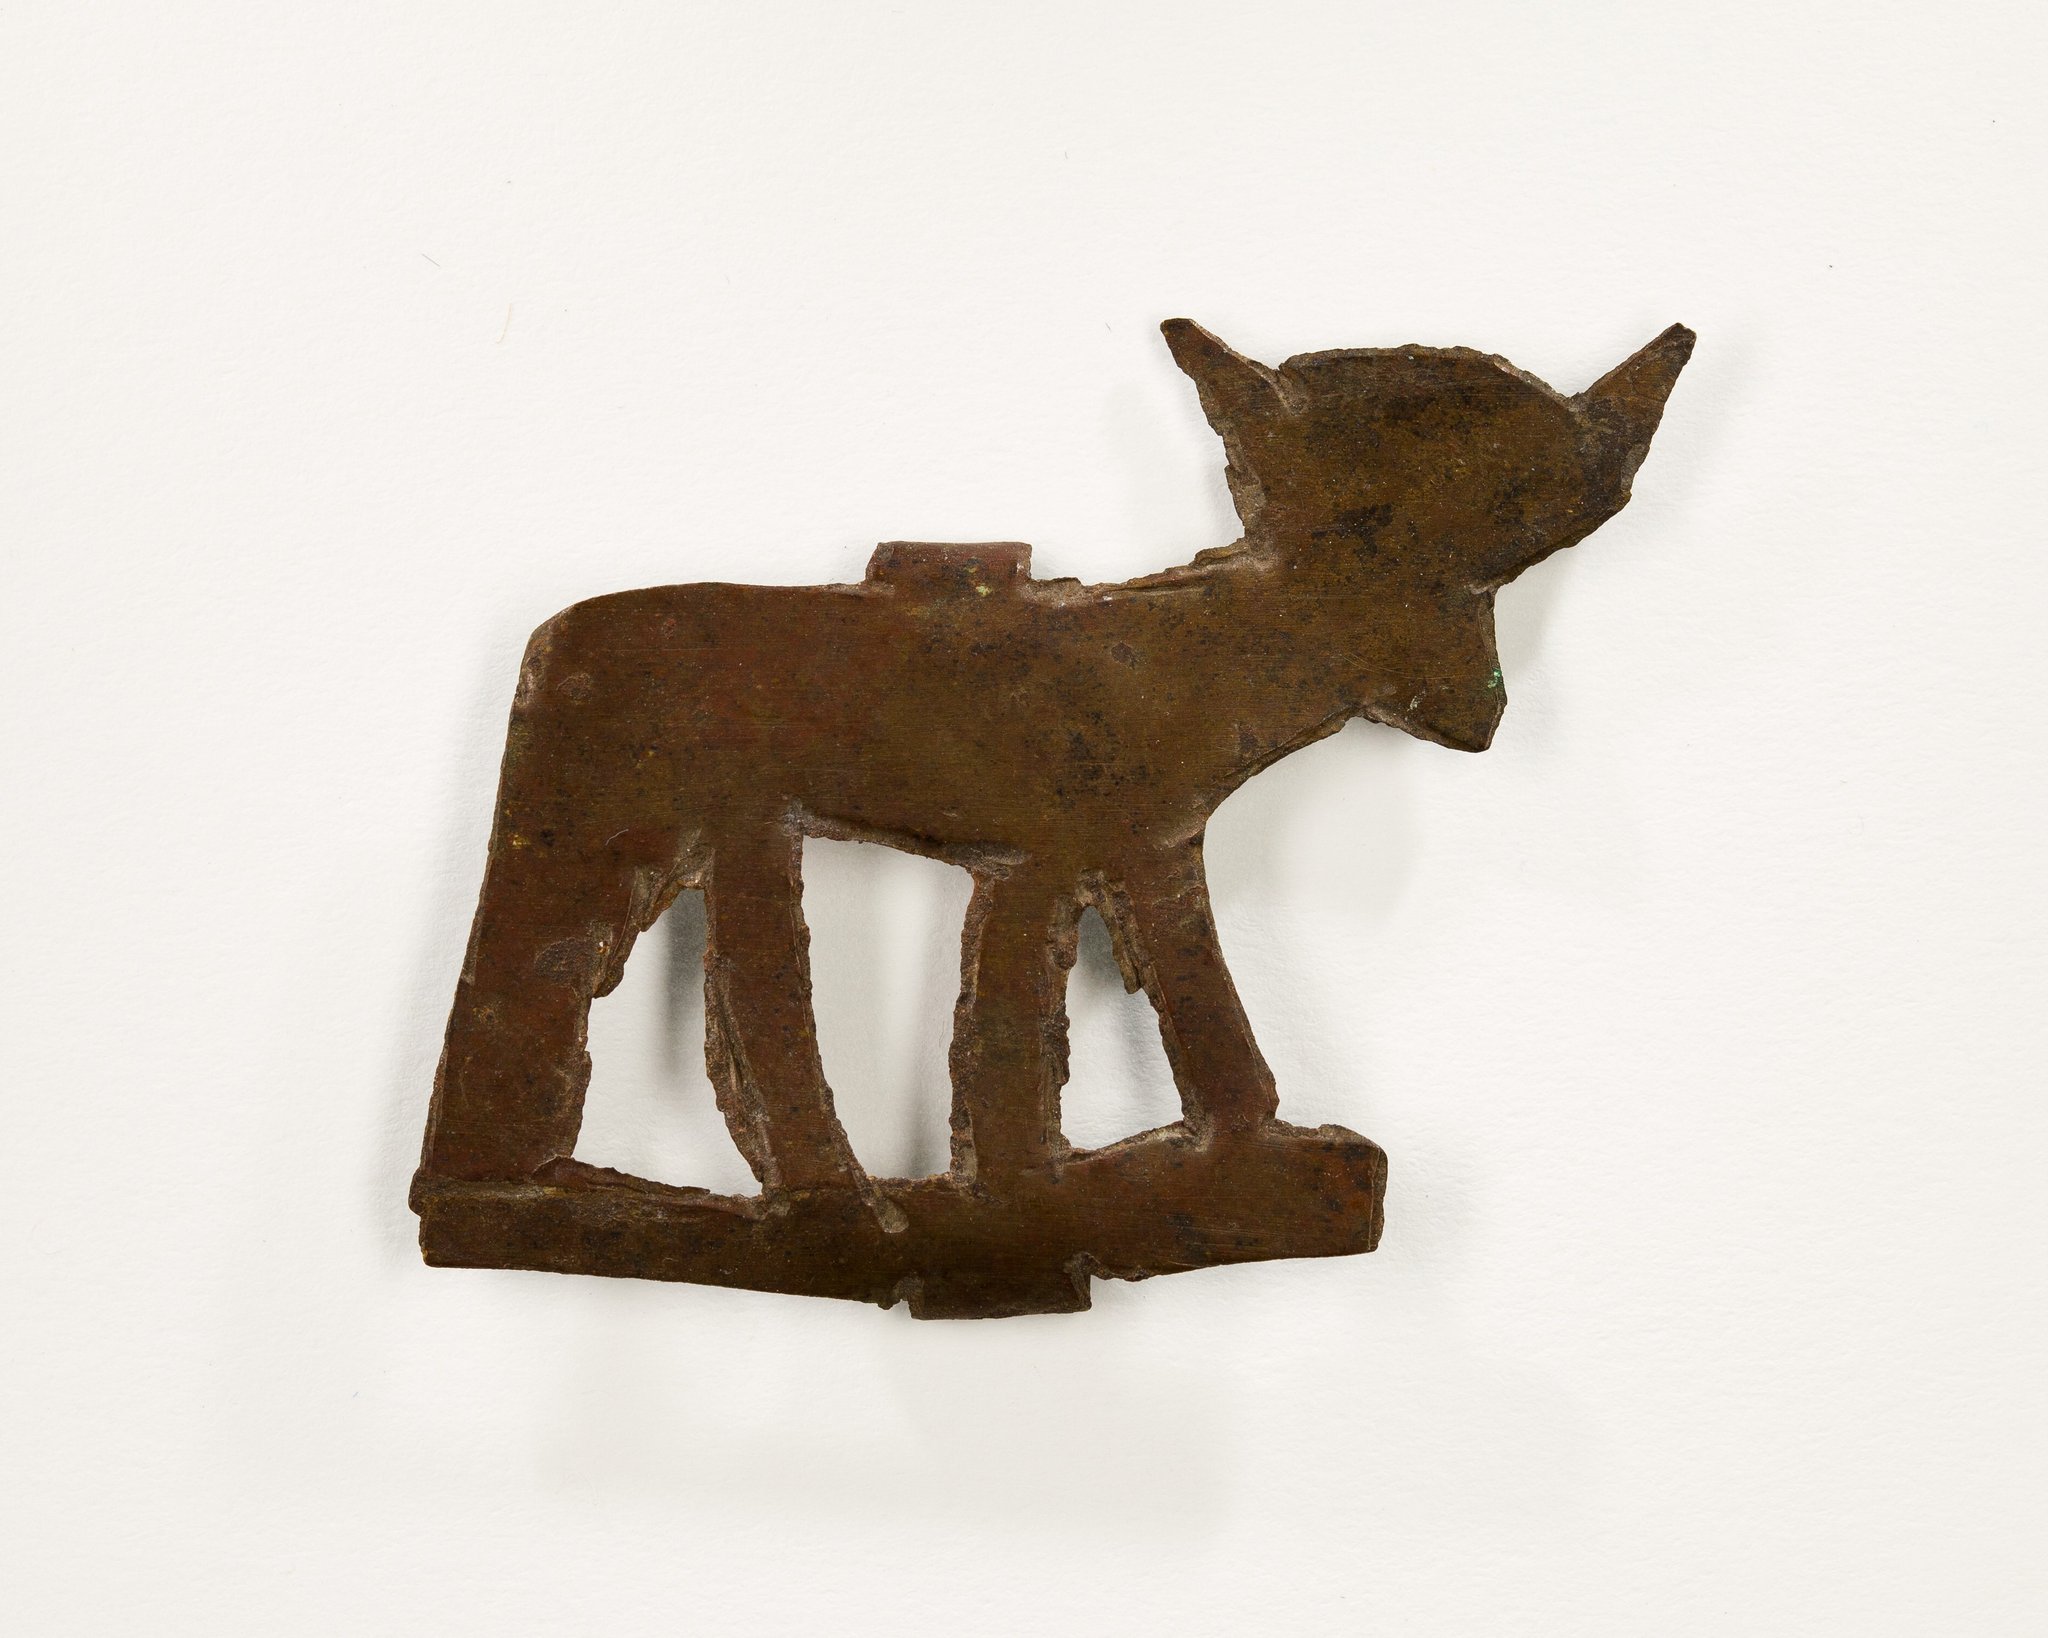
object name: votive, plaque, cow, hathor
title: Cow plaque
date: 1479-1458 BCE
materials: bronze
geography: egypt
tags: cows